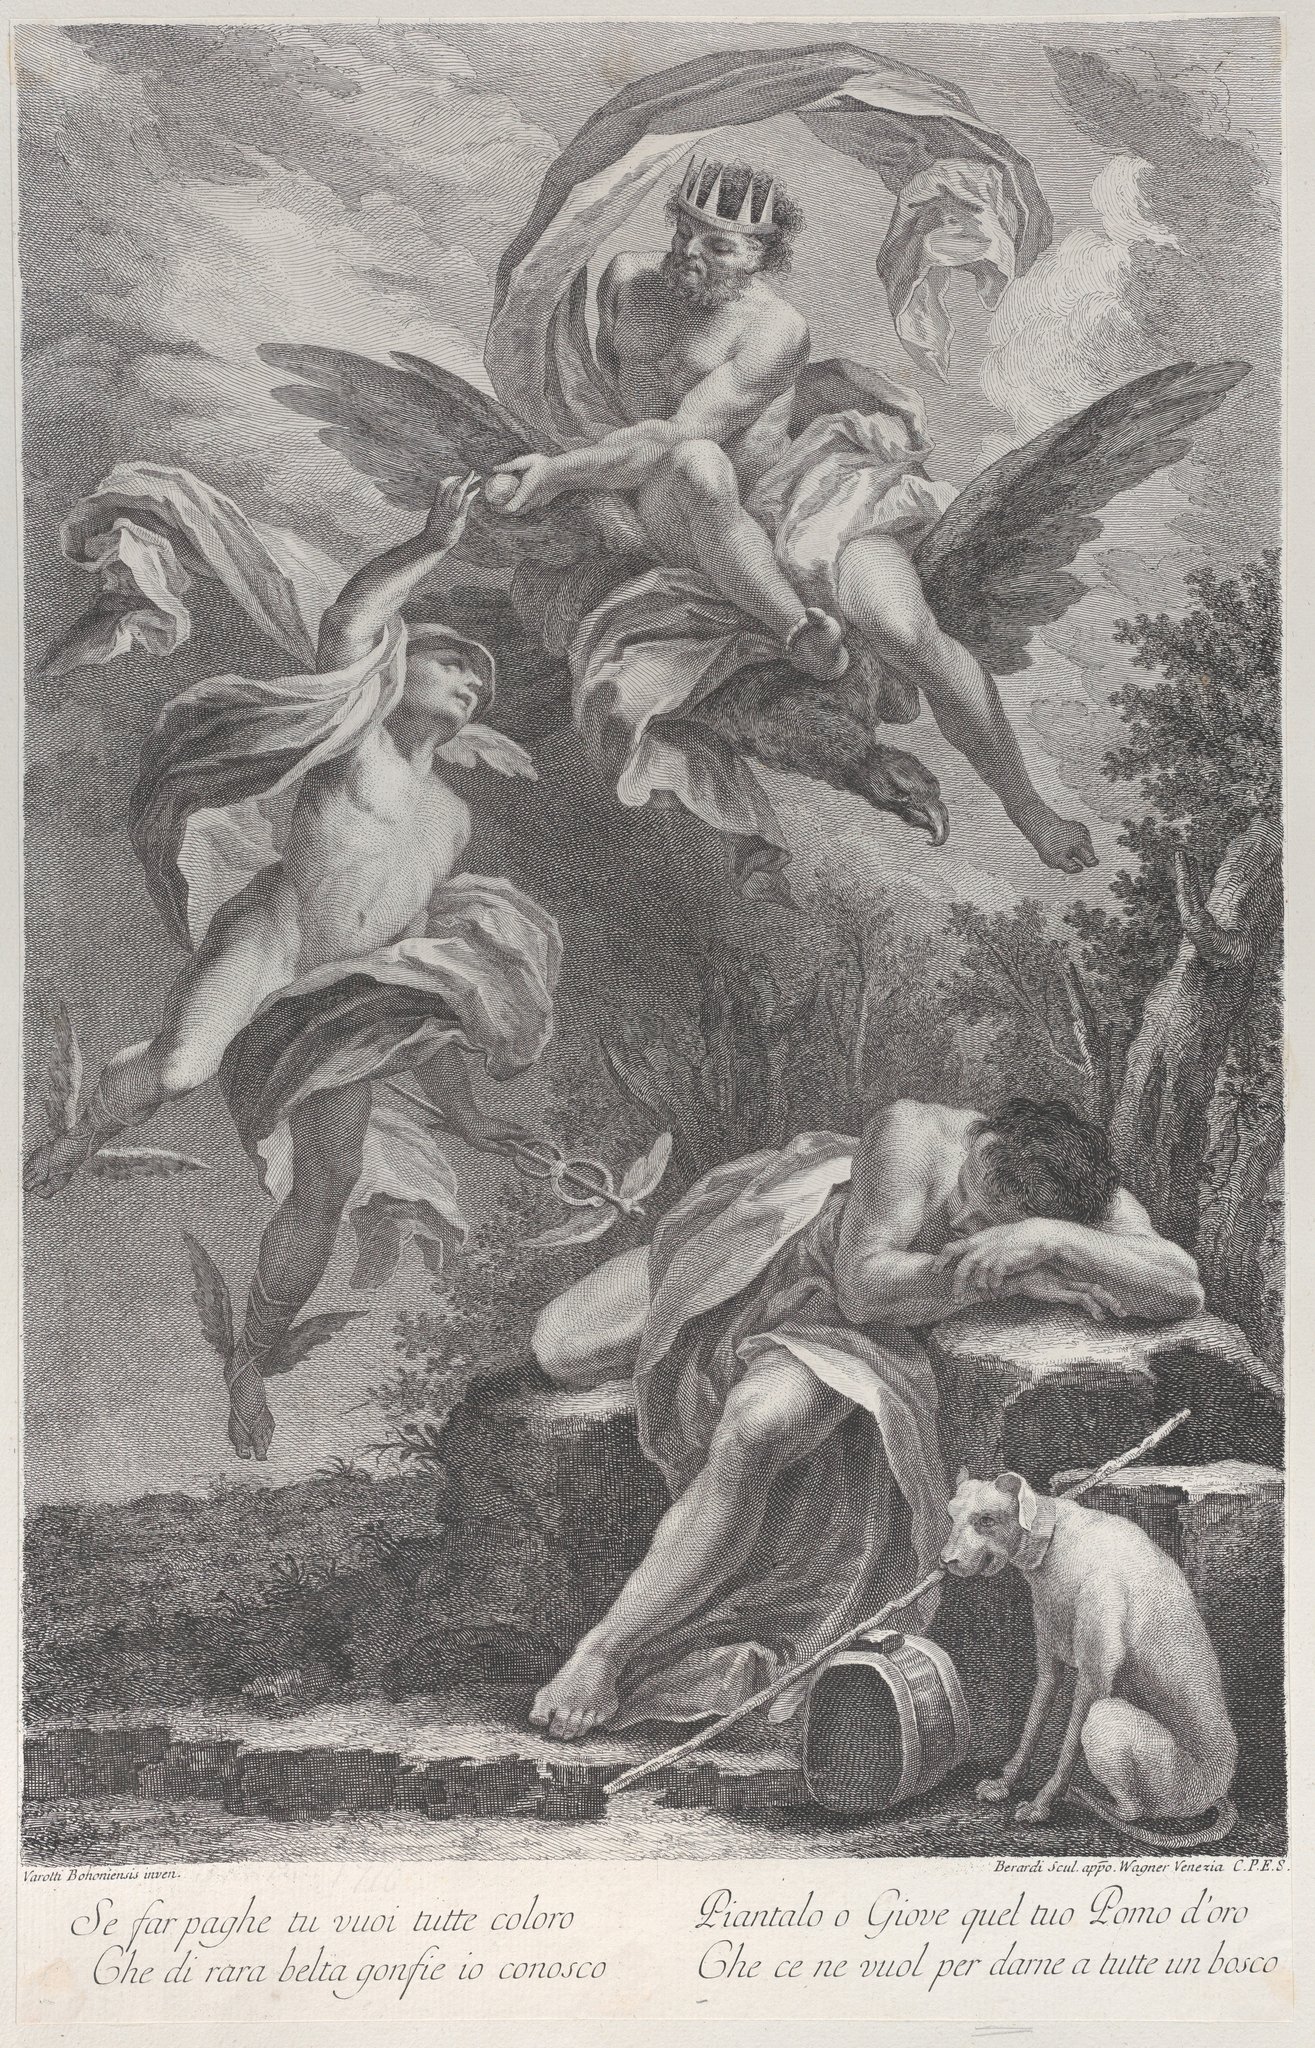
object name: print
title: Zeus handing the golden apple to Hermes, above the sleeping figure of Paris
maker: fabio berardi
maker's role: artist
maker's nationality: italian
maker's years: 1728-1788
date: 1748-1788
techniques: engraving, etching